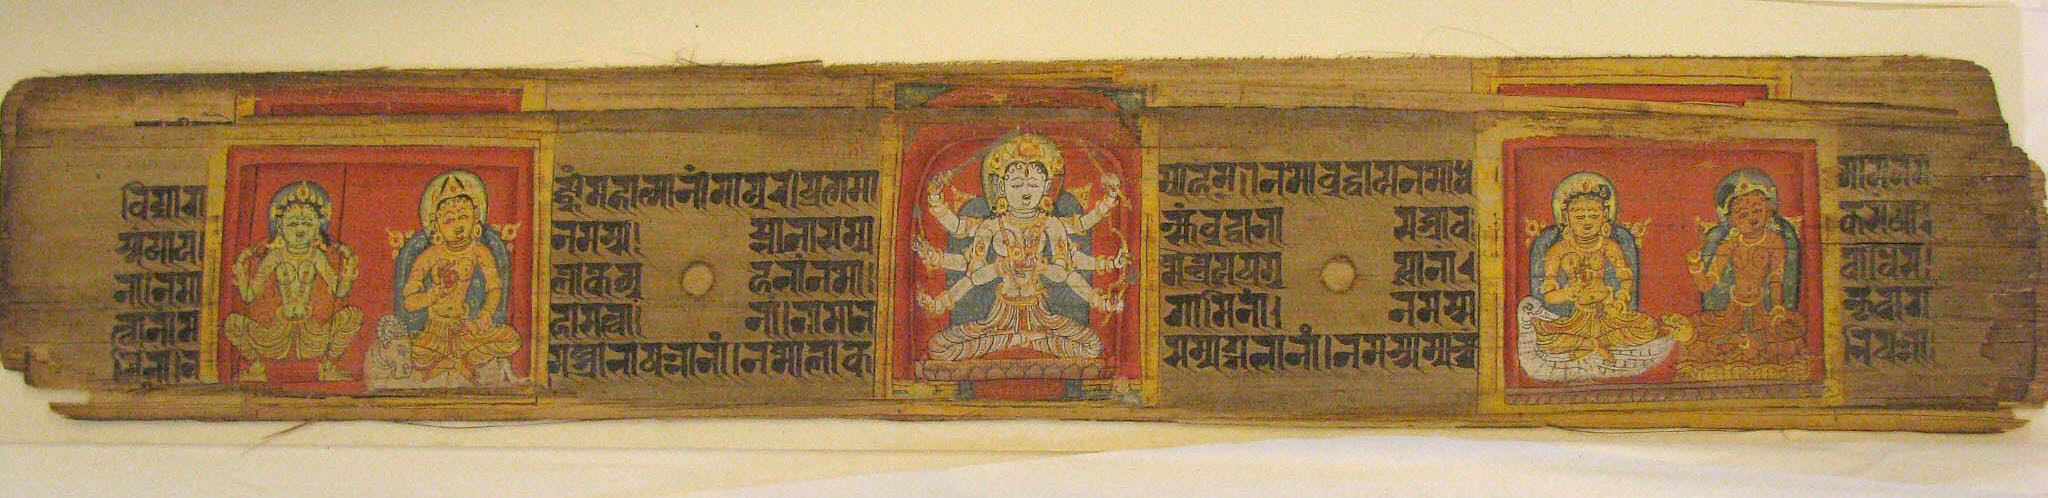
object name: folio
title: Leaf from an Illuminated Buddhist Manuscript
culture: nepali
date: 1301-1400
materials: ink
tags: buddhism,deities